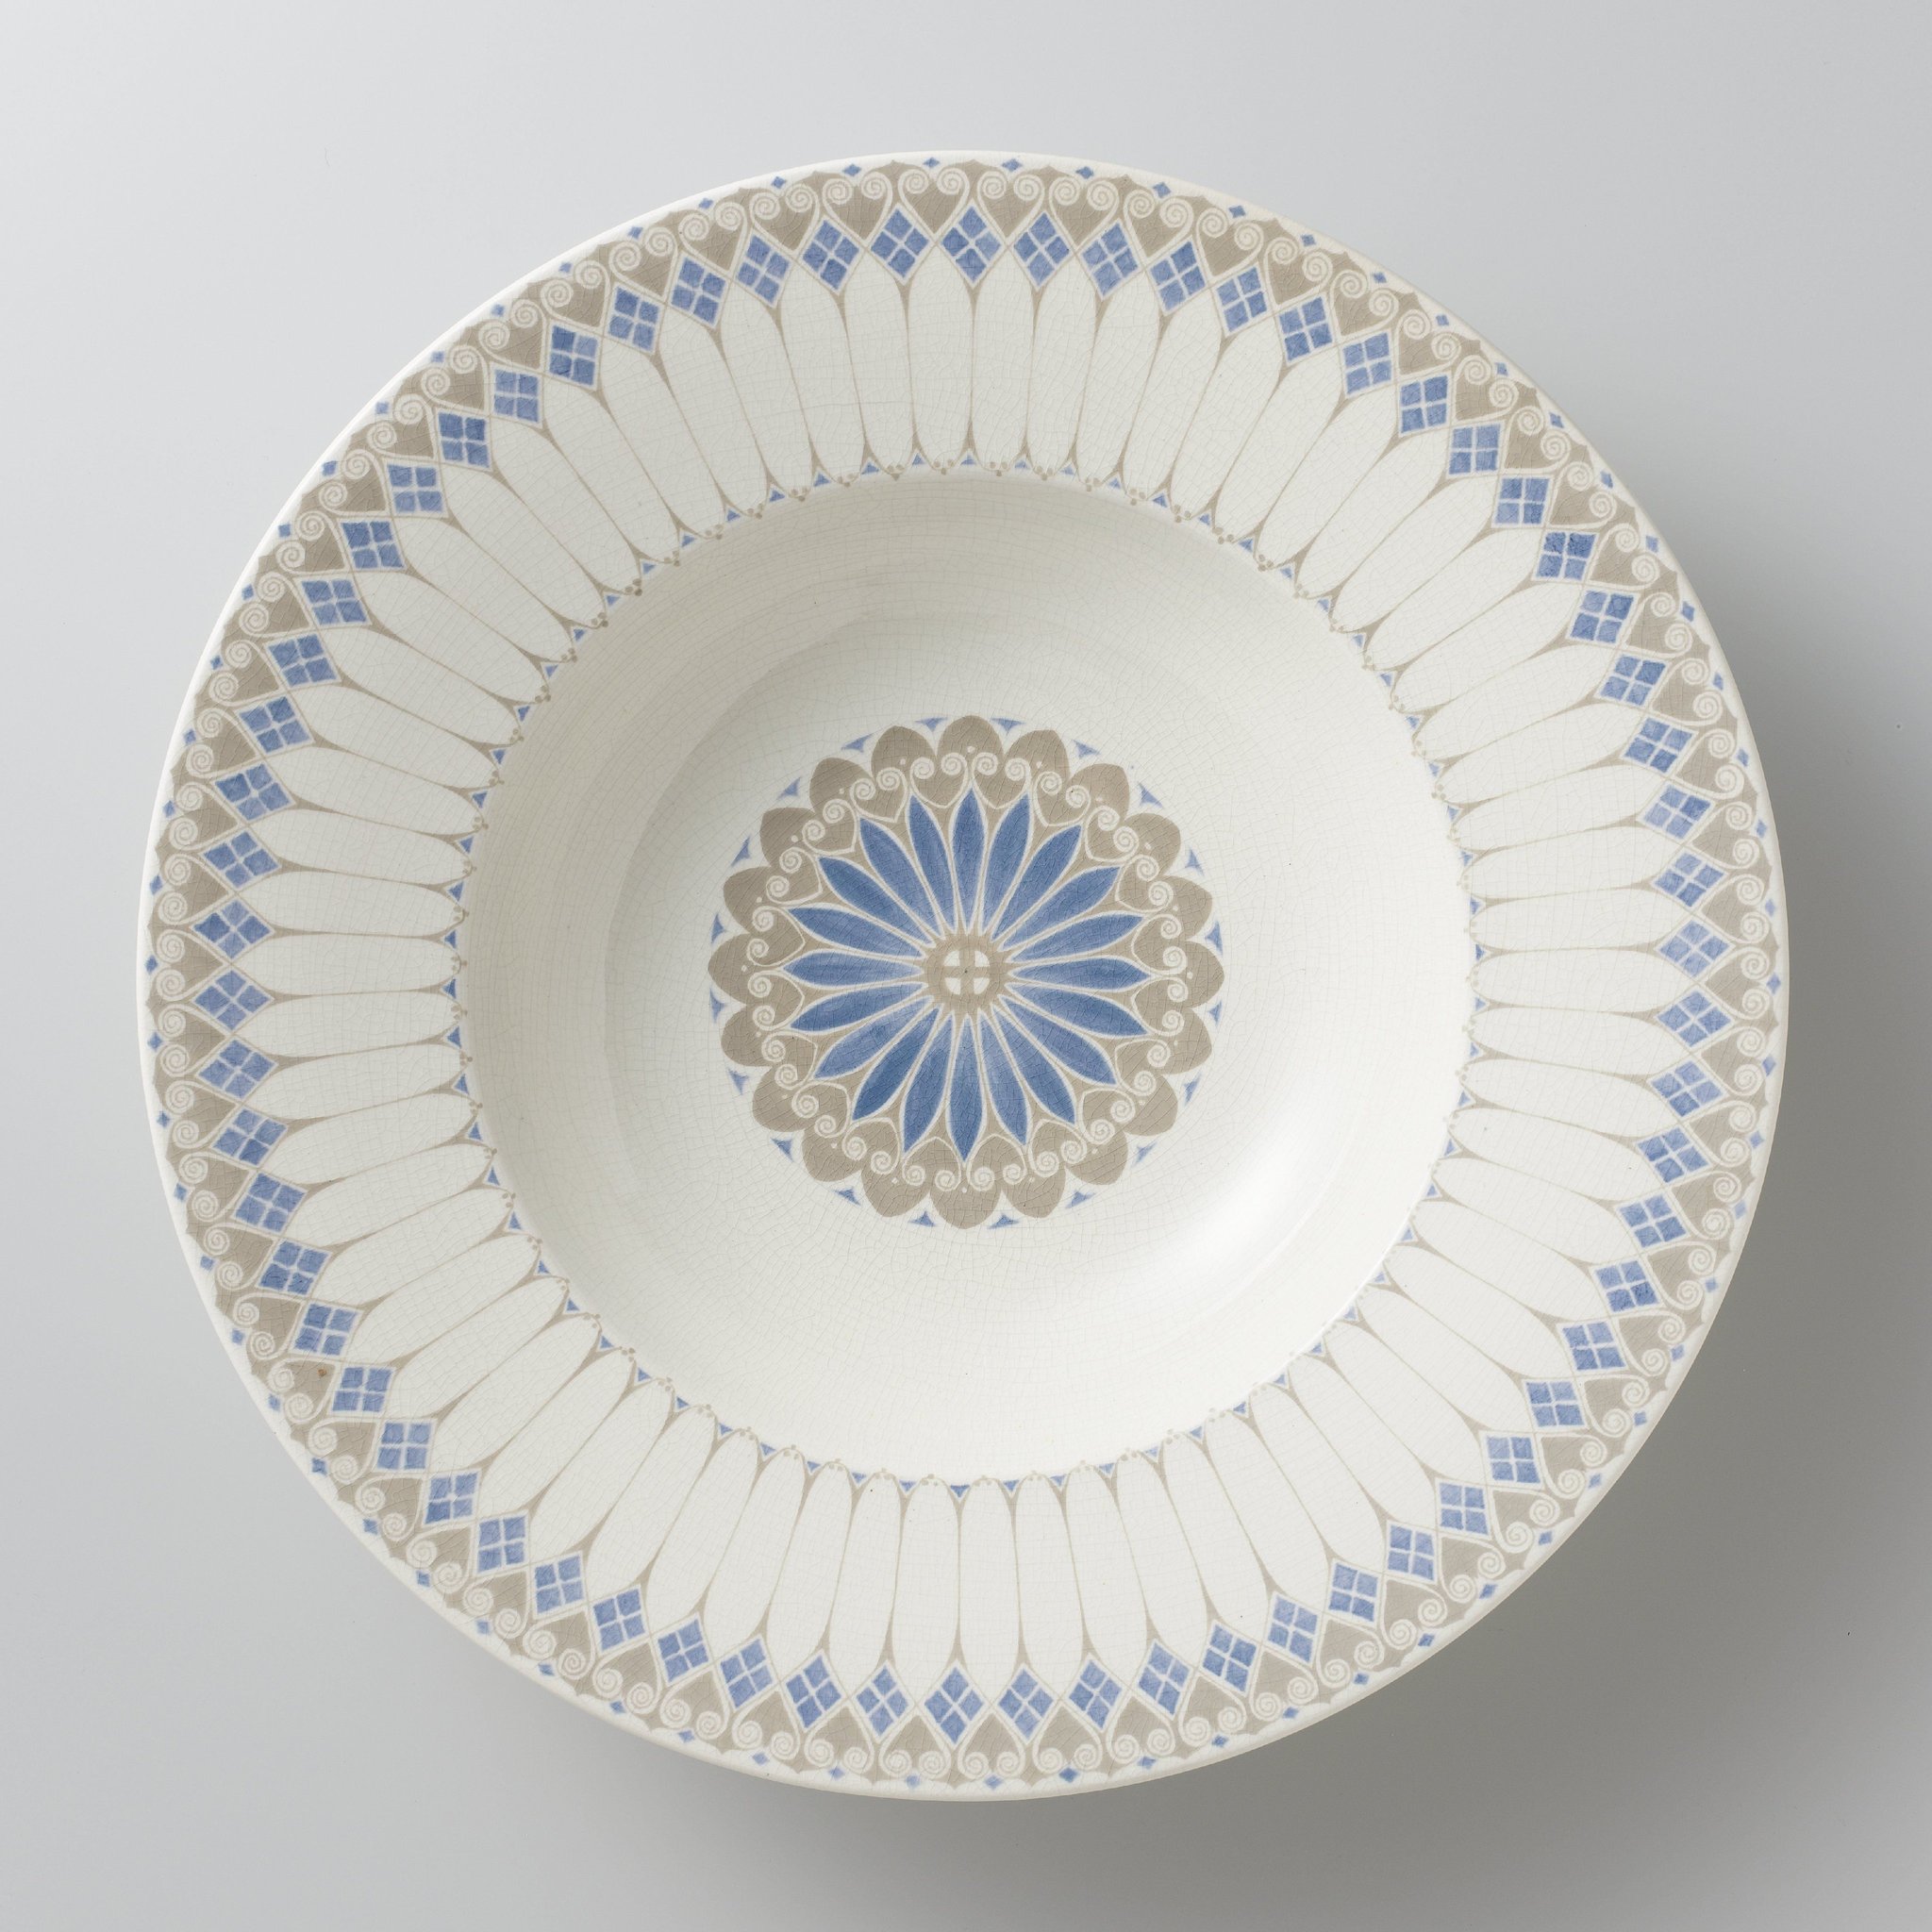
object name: platter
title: Sierschotel met rozetmotief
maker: chris van der hoef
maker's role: ceramicist, draughtsman, sculptor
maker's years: 1875-1933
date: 1905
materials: earthenware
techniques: painted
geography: netherlands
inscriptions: mark: ‘in lichtblauw: W.v.M.; de letters DW onder elkaar in een cirkel; hieronder Van der Hoef in zwart’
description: Dish. Earthenware. Gouda, Plateelbakkerij Zuid-Holland for De Woning, c. 1905, designed by Christiaan J. van der Hoef, decorated by W.v.M.